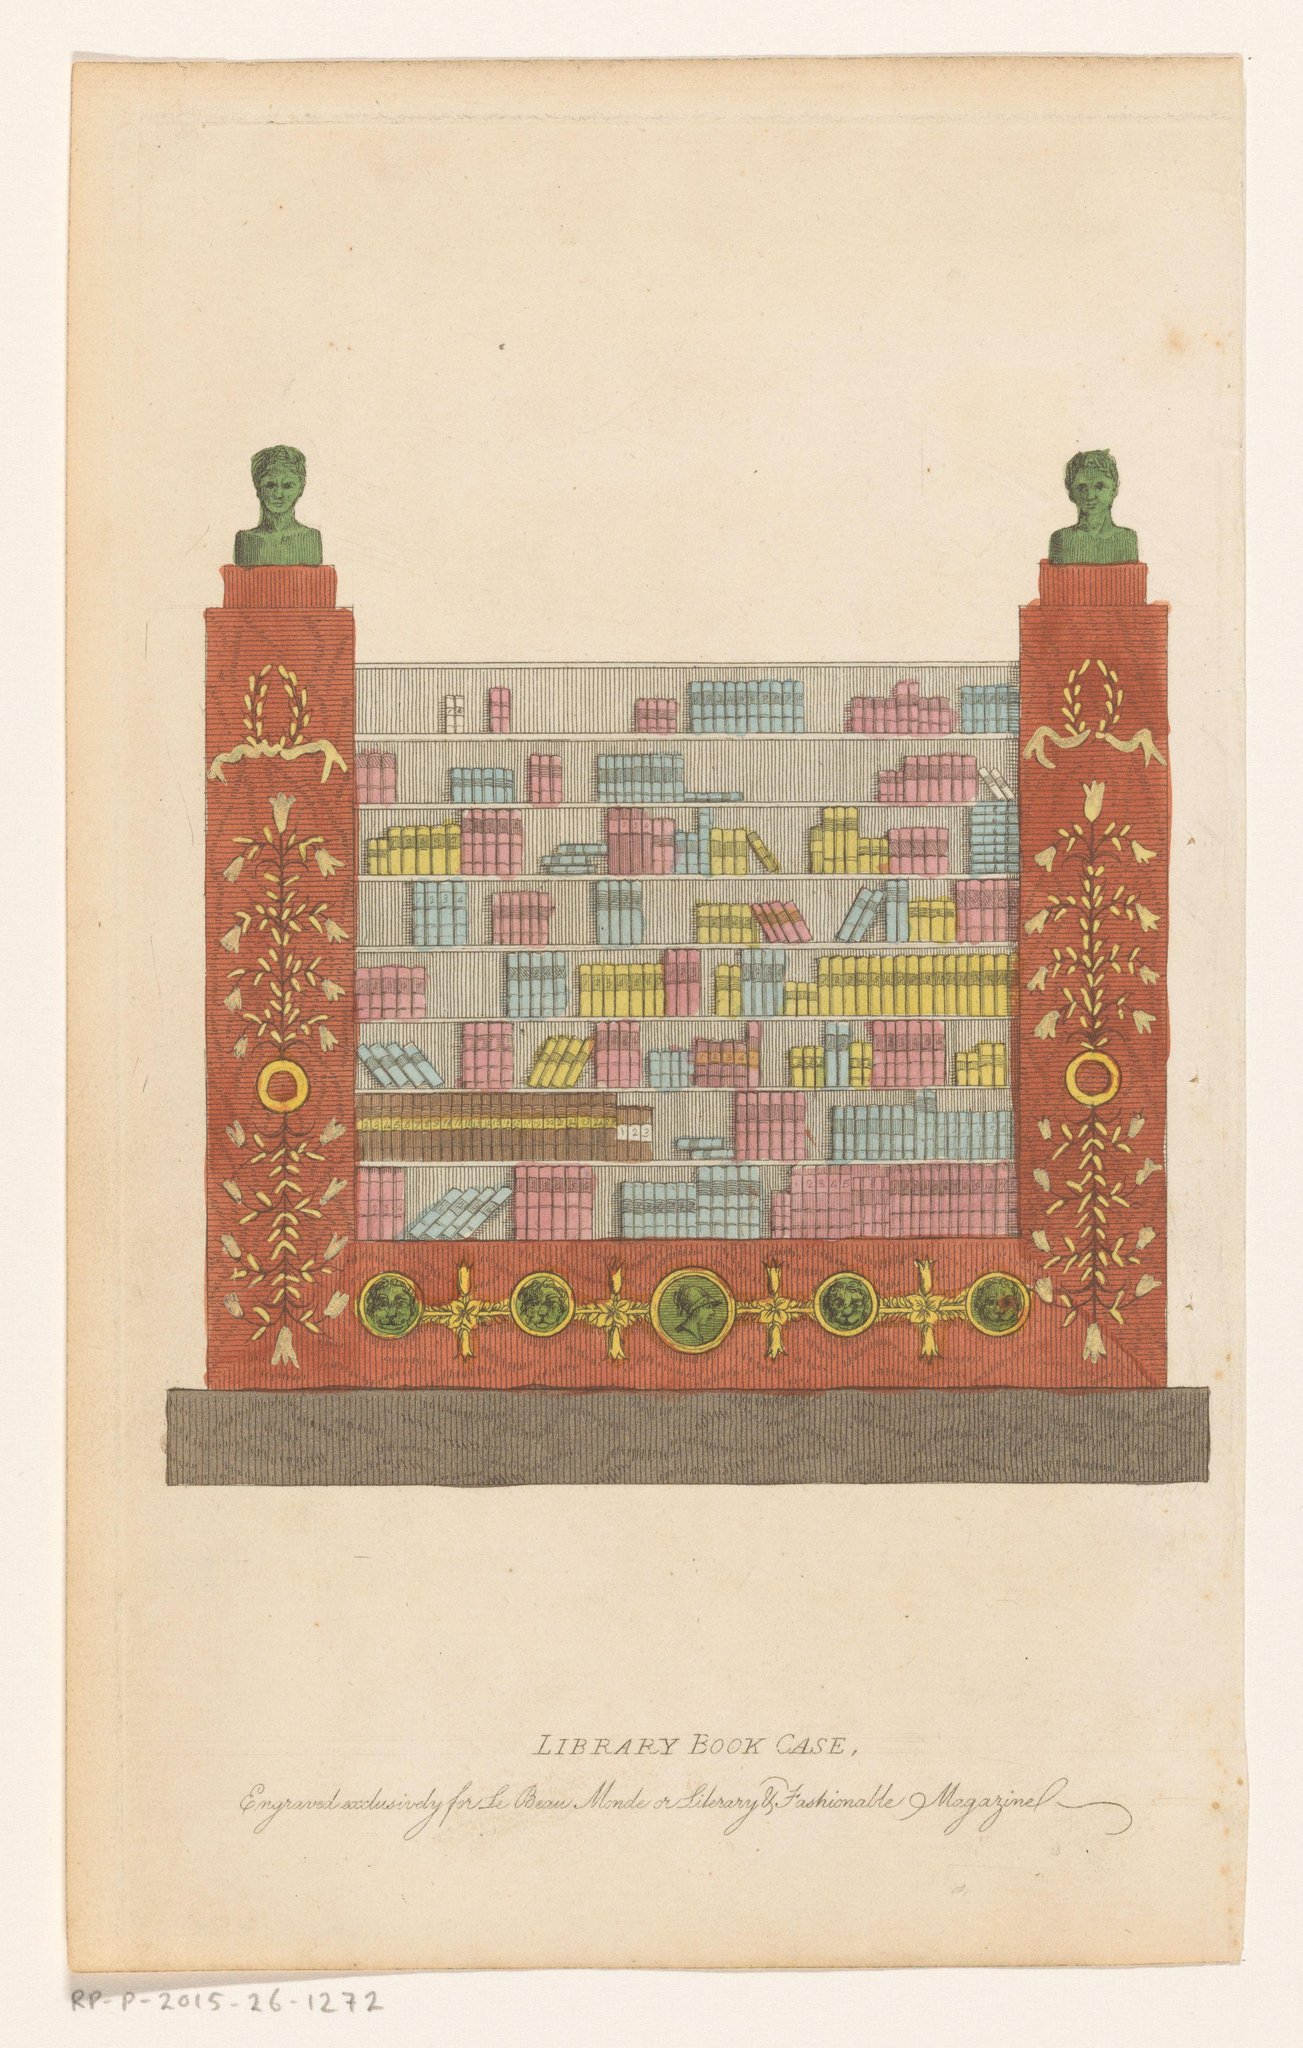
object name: print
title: Boekenkast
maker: Anonymous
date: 1806-1809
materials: paper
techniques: etching, hand coloring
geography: london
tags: bookshelves, furniture for storage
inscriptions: collector's mark: Lugt 2228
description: Prent waarschijnlijk afkomstig uit het tijdschrift 'Le beau monde, or, Literary and fashionable magazine', uitgegeven tussen 1806-1809.